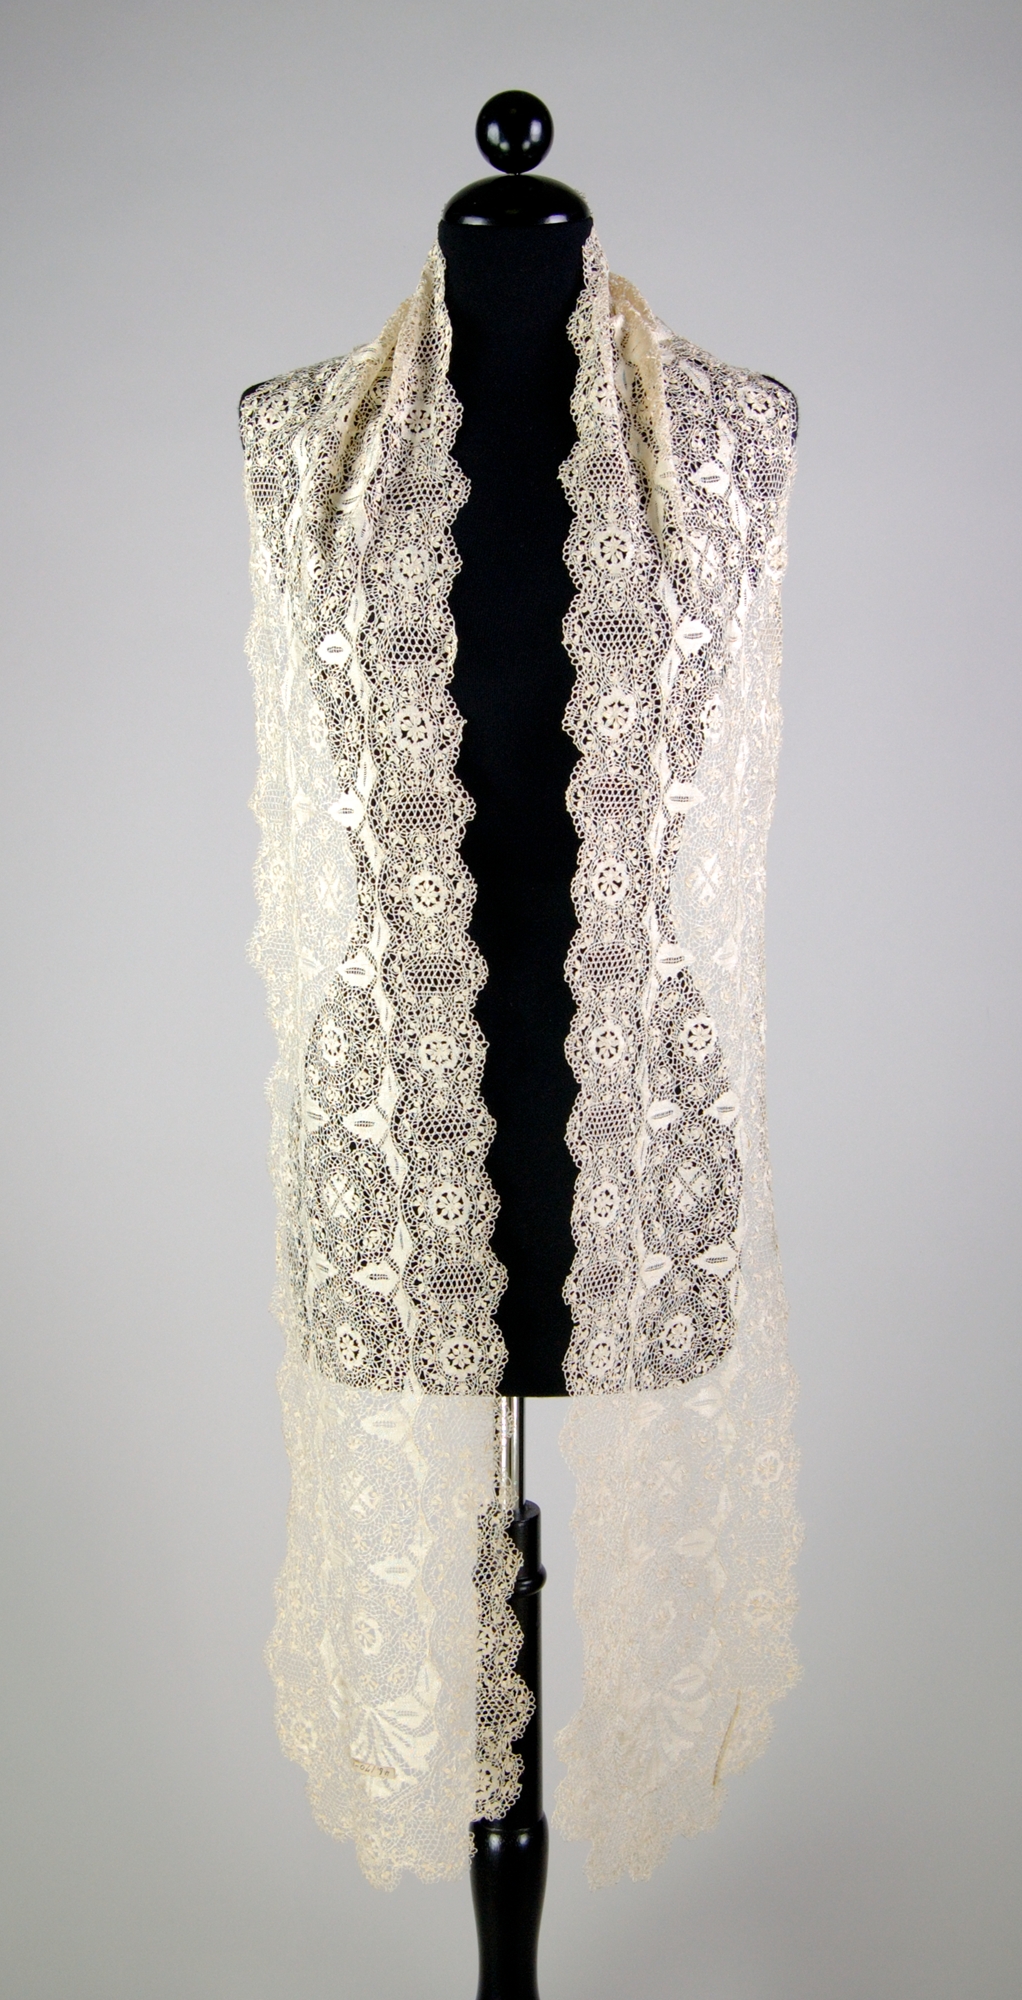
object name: stole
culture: maltese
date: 1876-1900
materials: silk